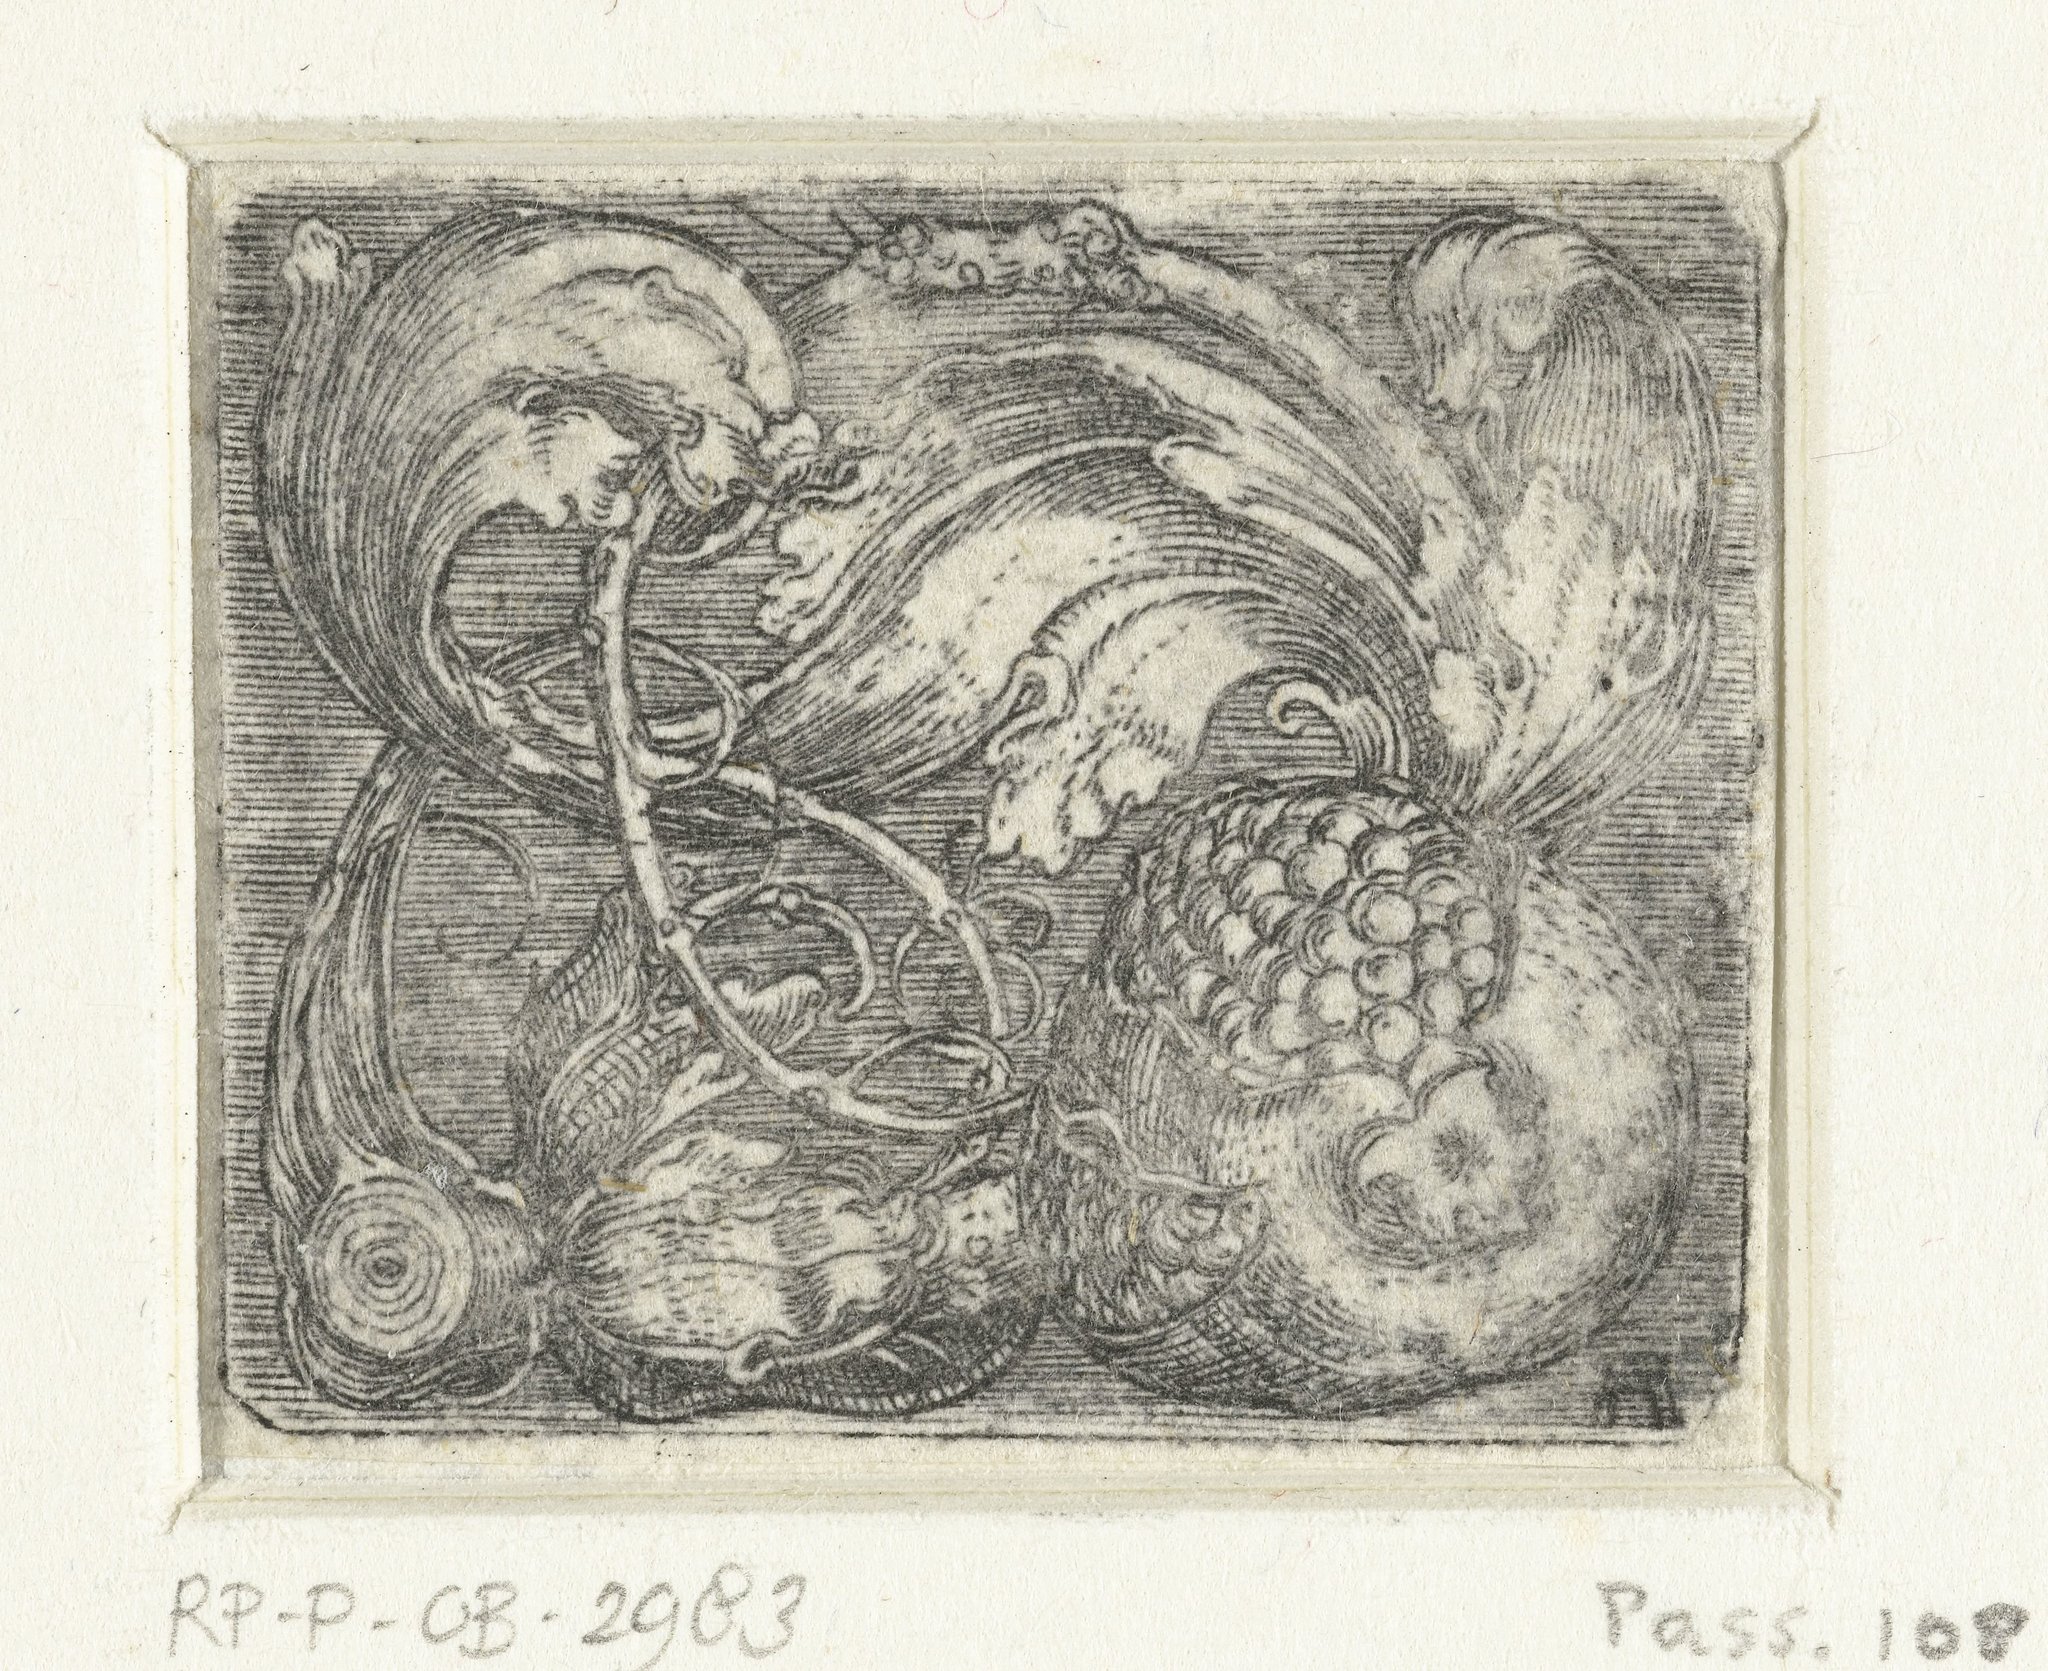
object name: print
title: Granaatappel en bladranken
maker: albrecht altdorfer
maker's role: draughtsman, print maker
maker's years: 1480-1538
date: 1506-1538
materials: paper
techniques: engraving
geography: germany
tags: pomegranate ~ ornament, foliage, tendrils, branches ~ ornament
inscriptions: number: ‘4’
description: Vlakdecoratie met een opengebasten granaatappel en bladranken.